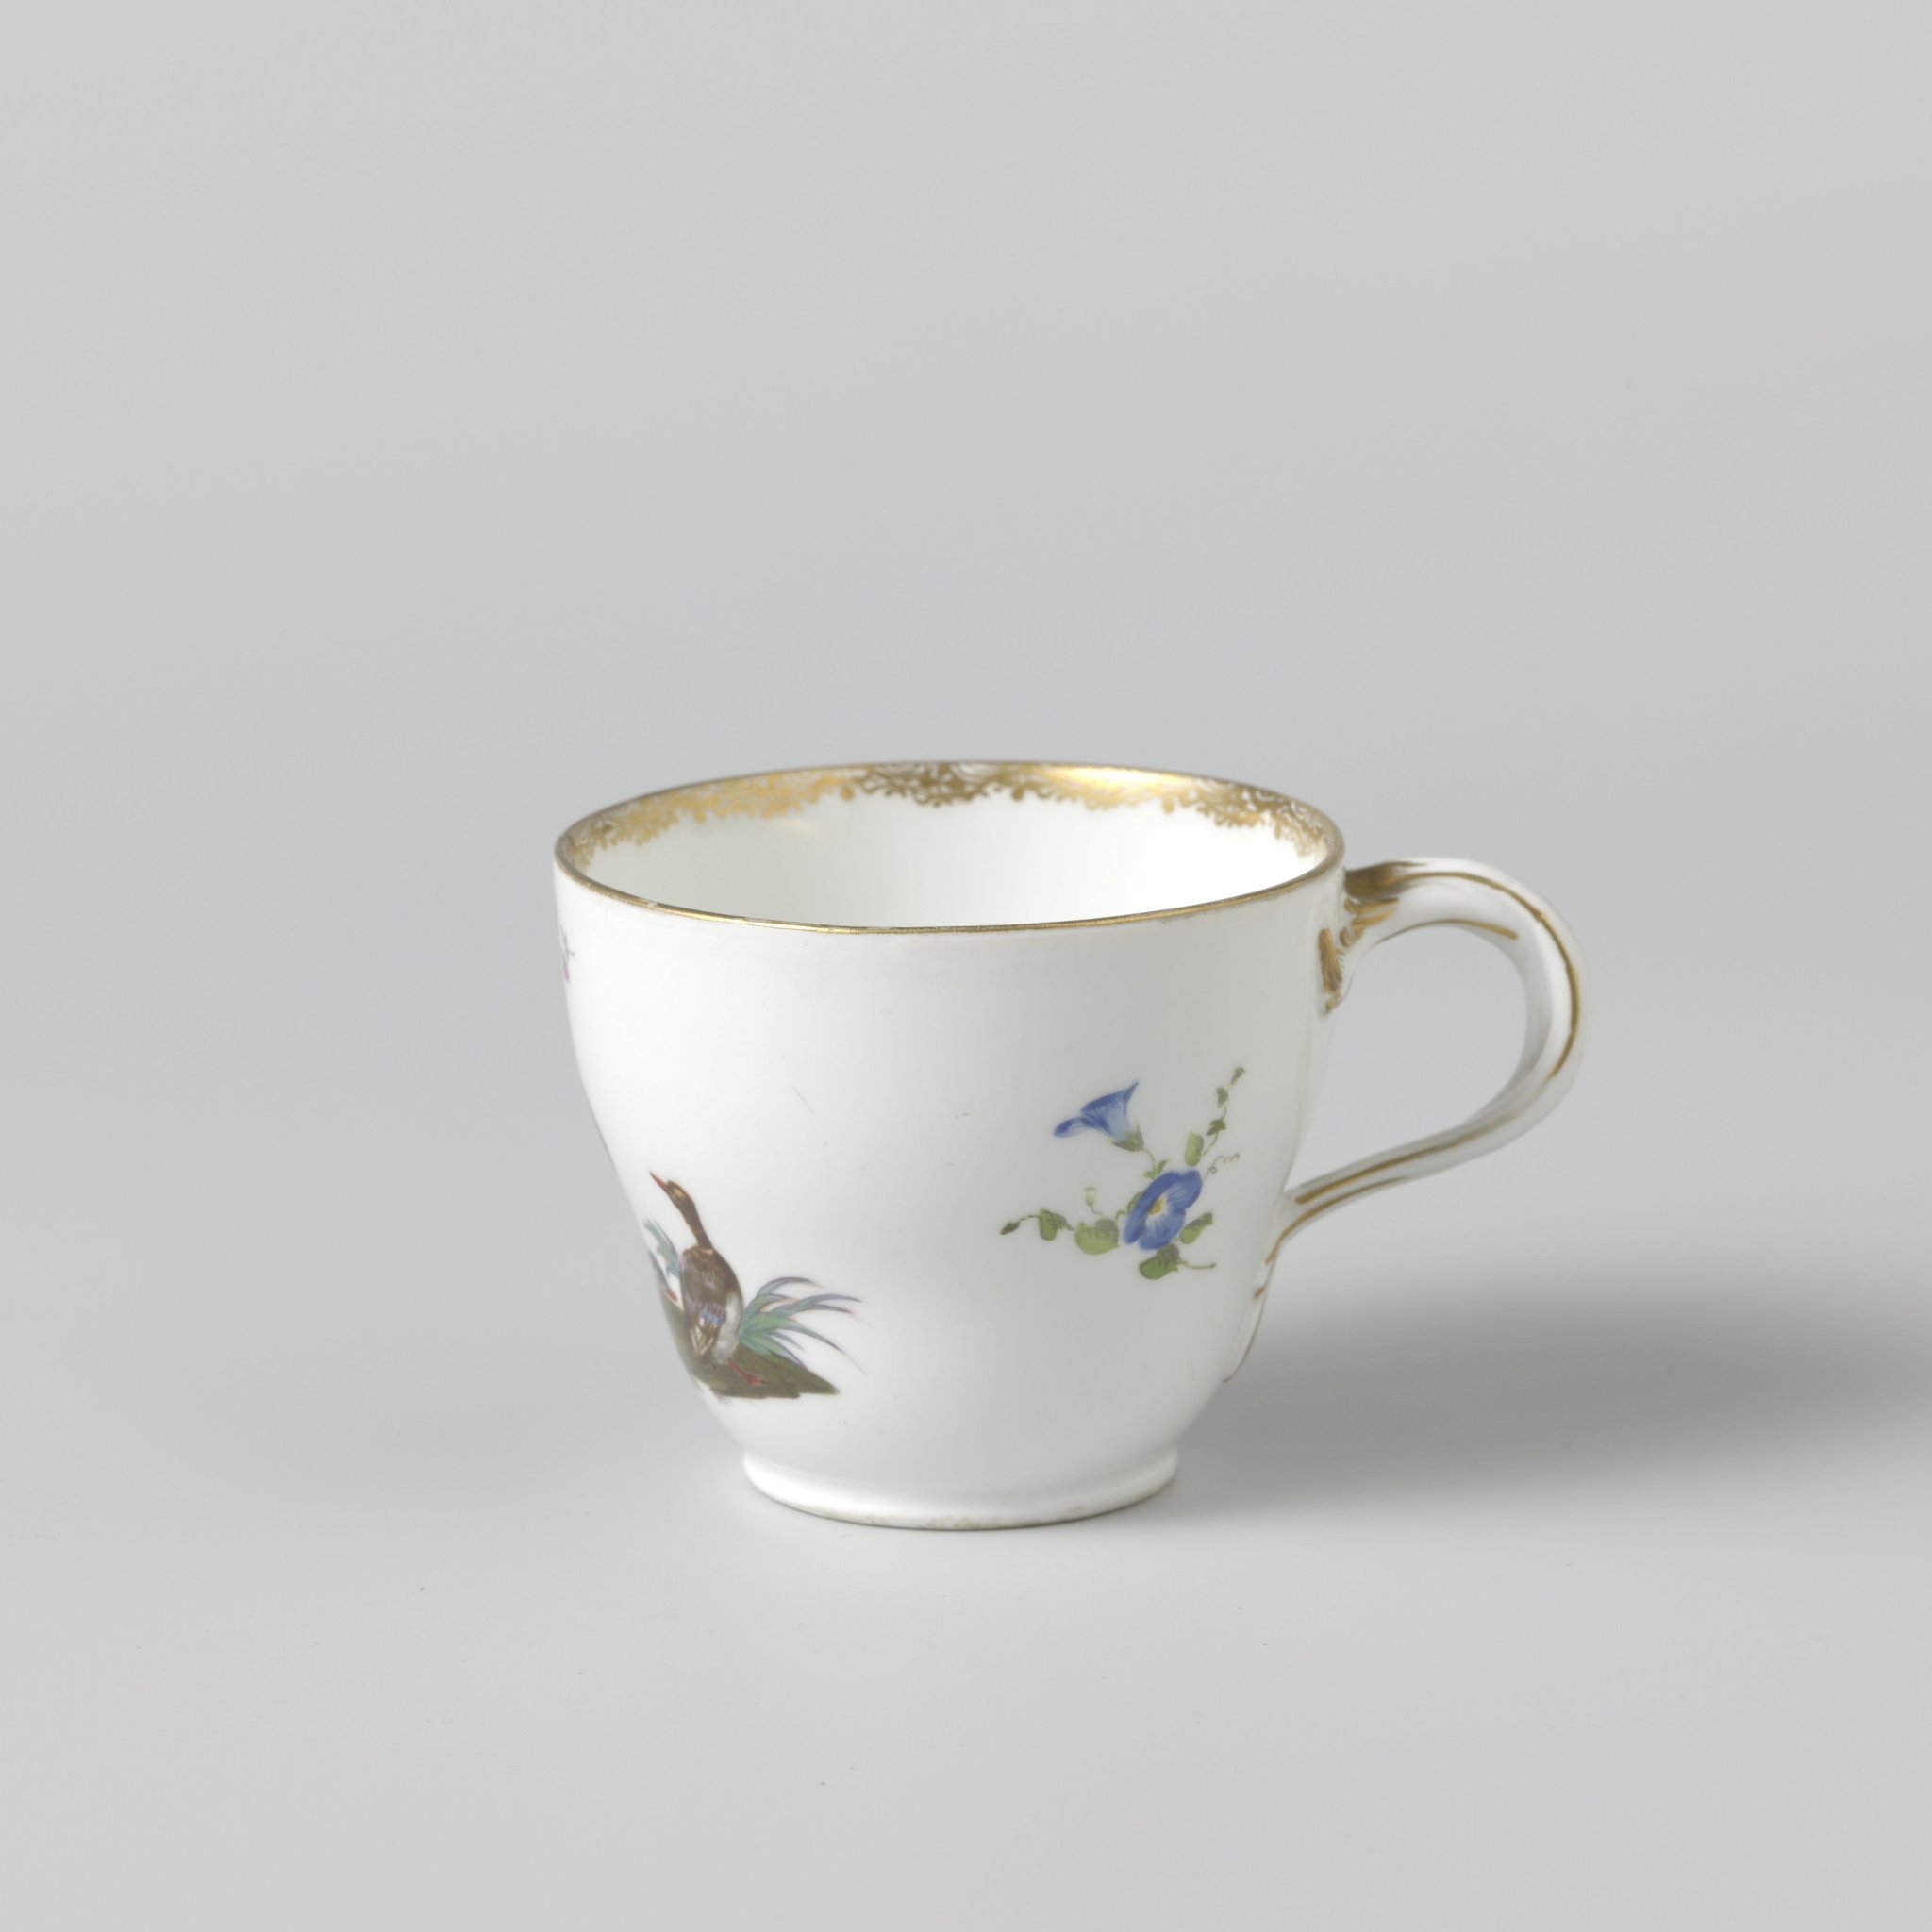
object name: eating drinking utensil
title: Kop, veelkleurig beschilderd vogels en bloemtakken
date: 1770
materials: porcelain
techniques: painted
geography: meissen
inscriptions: factory mark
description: Halfbolvormige kop van beschilderd porselein. De kop heeft een oor in de vorm van twee met elkaar verstrengelde takken. De kop is beschilderd met vogels op een grond en bloemtakken. Langs de binnenrand loopt een ornamentrand in goud. De kop is gemerkt.